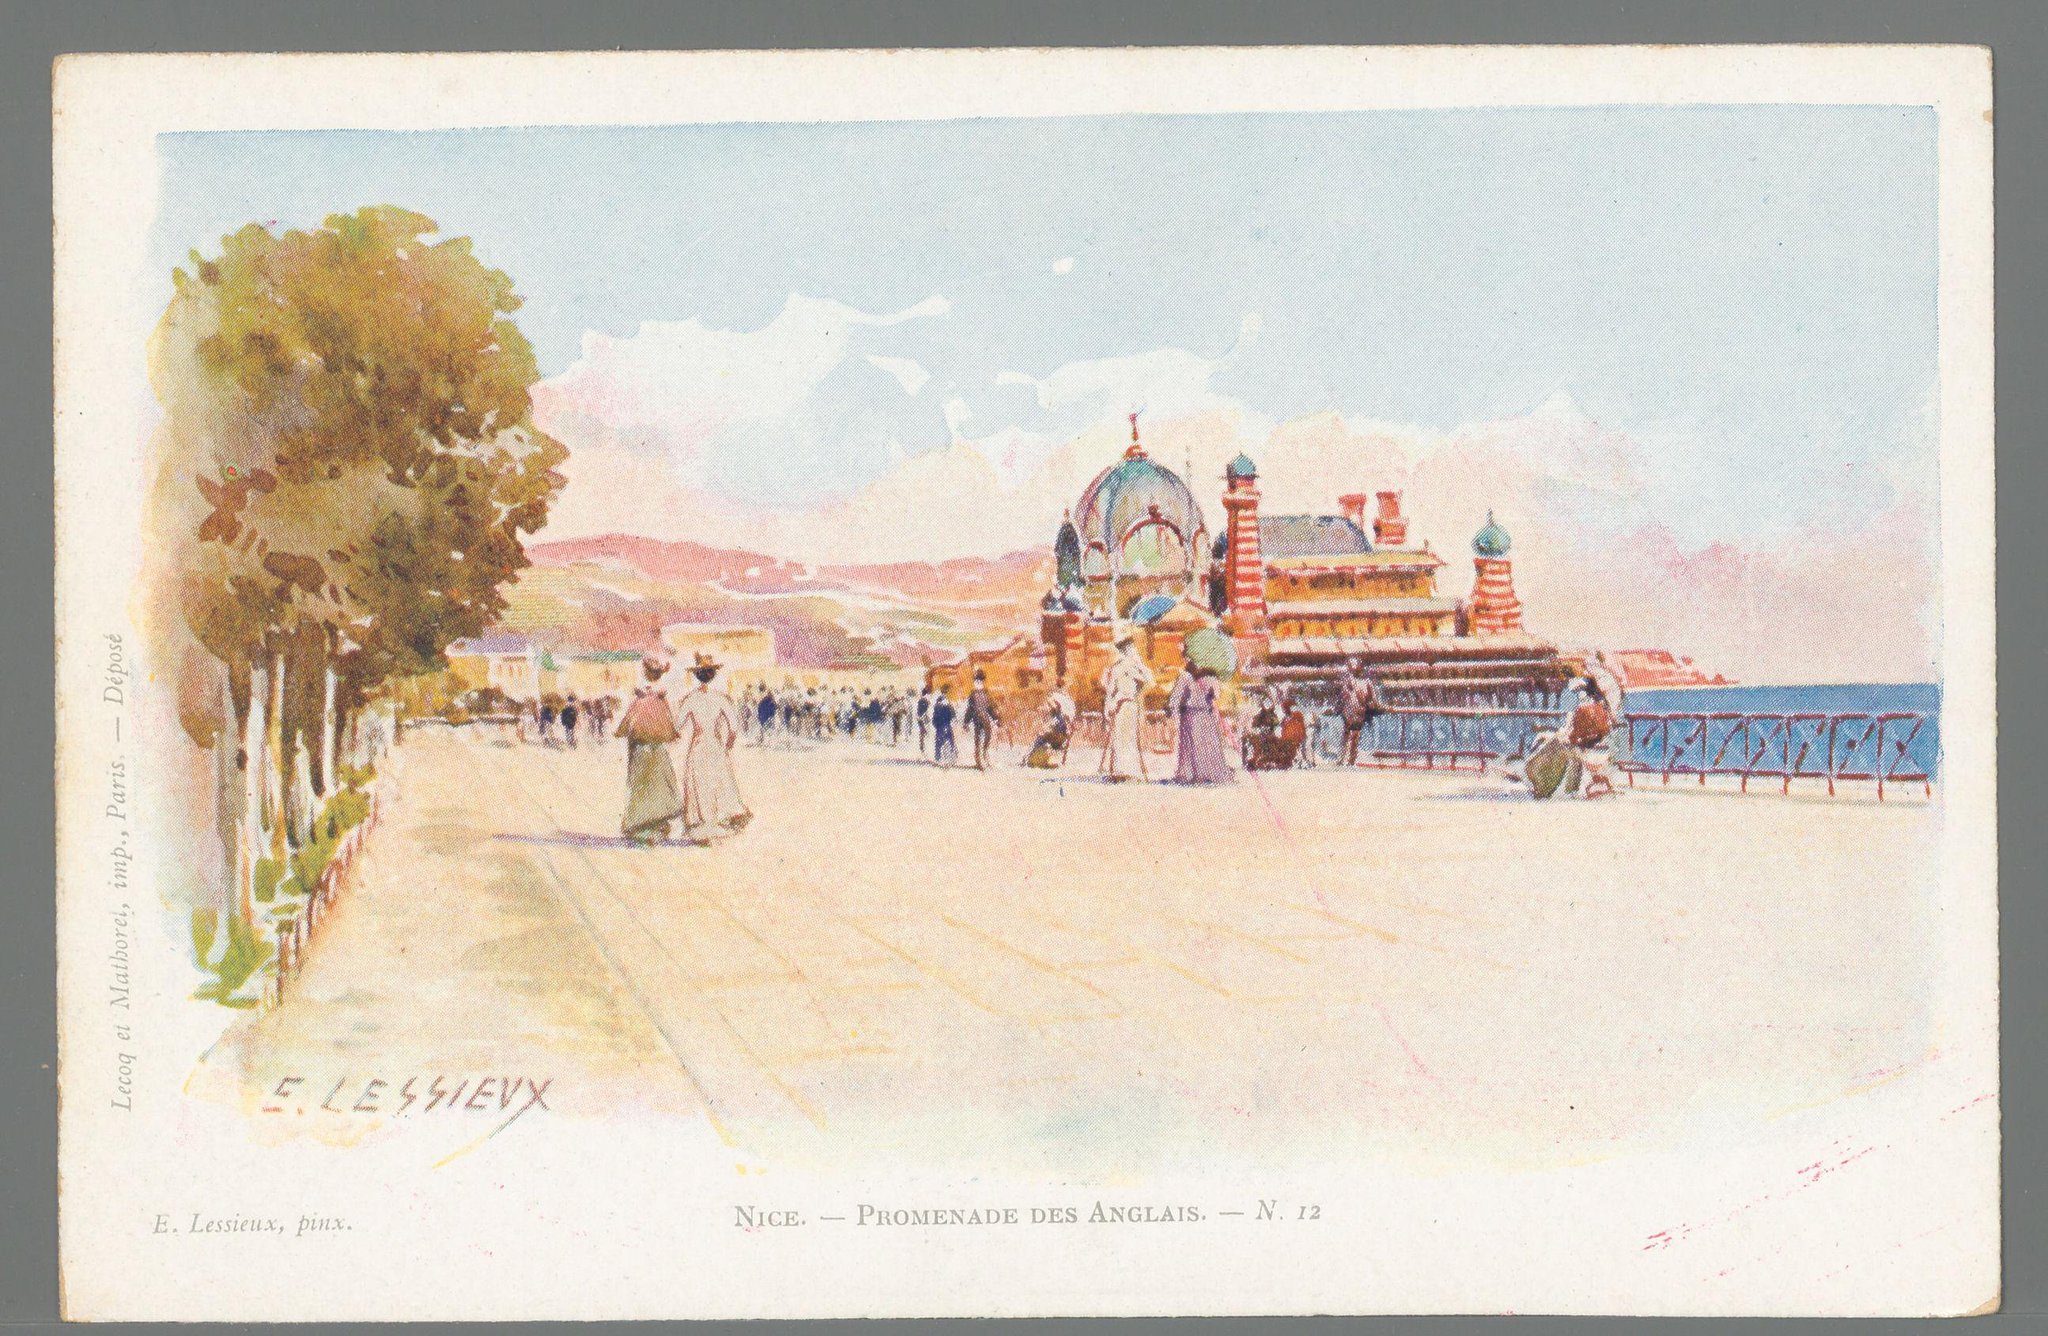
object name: reproduction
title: Nice. Promenade des Anglais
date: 1892-1904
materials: cardboard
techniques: writing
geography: paris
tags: avenue, boulevard, promenade, esplanade (+ city(-scape) with figures, staffage), landscapes with waters, waterscapes, seascapes (in the temperate zone)